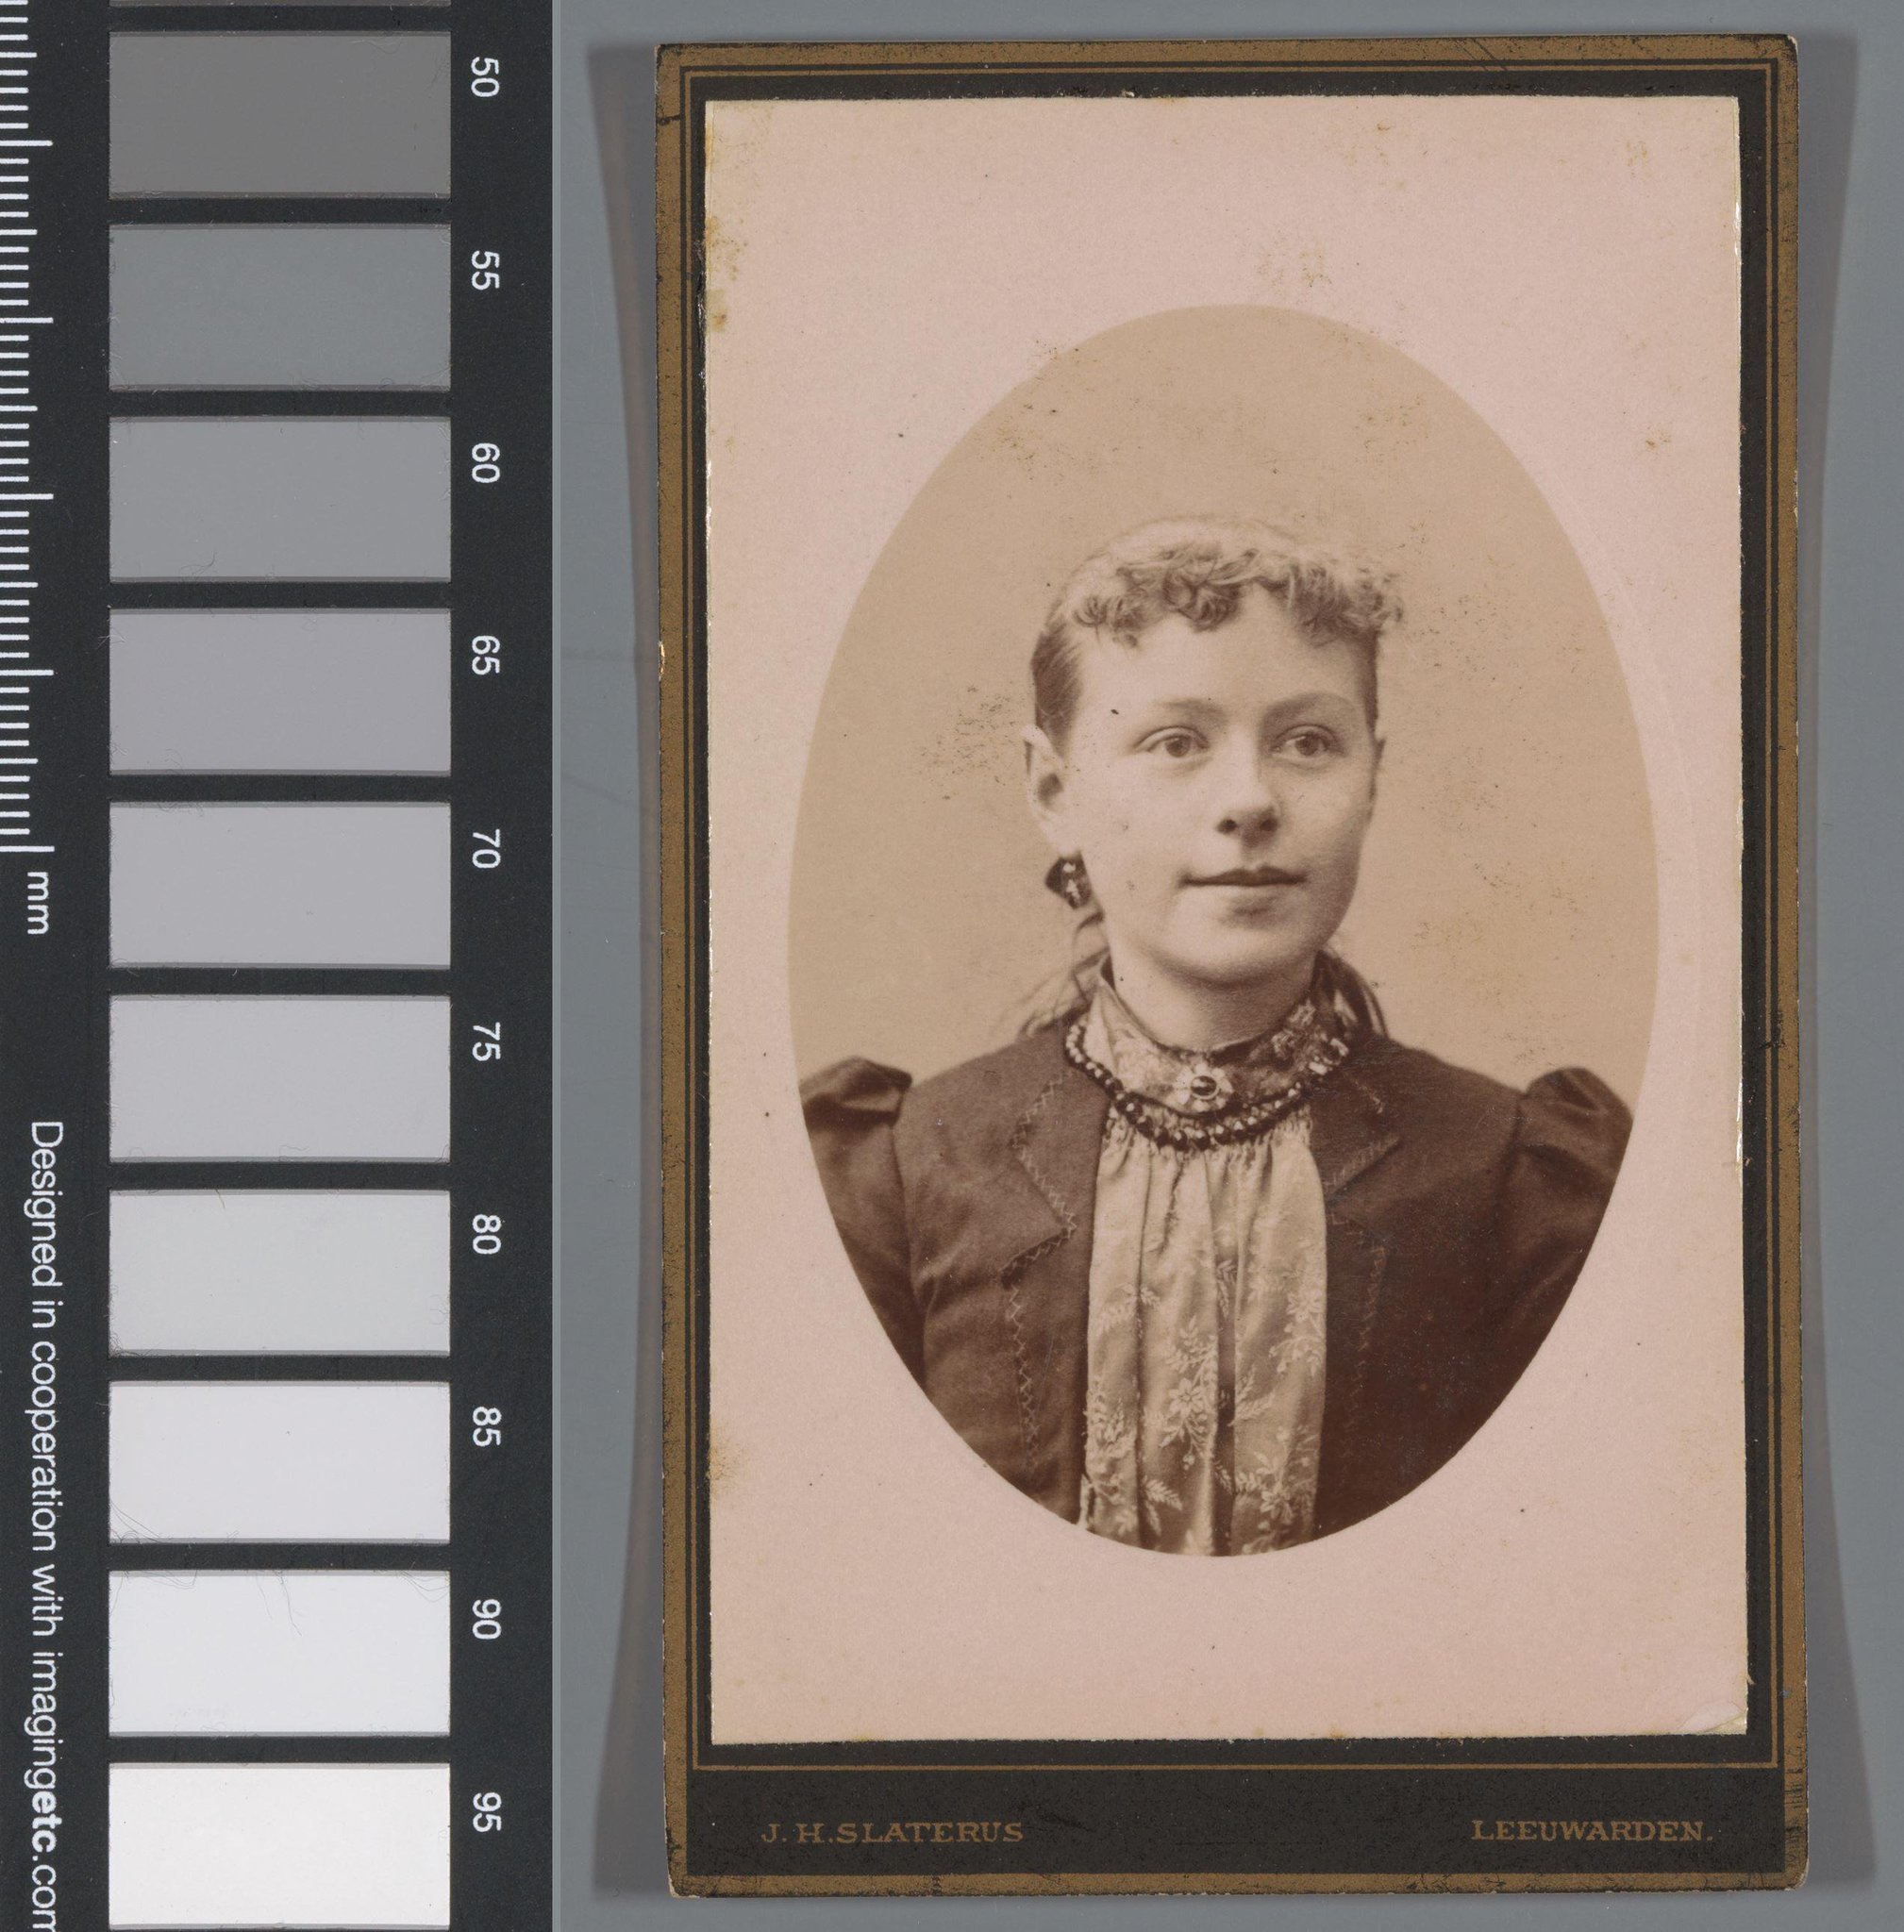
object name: photograph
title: Portret van Ienkje Gal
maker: idanus hendrikus slaterus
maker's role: fotograaf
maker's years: 1846-1921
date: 1892-1909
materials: cardboard, celluloid, paper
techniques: albumen print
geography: leeuwarden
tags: historical persons - bb - woman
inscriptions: inscription: ‘Photographie Instantanée/ J. H. Slaterus/ LEEUWARDEN, Langemarktstraat/ tegenover het Station bij de nieuwe Veemarkt./ Lef. W. No. 14.’, inscription: ‘Ienkje Gal’